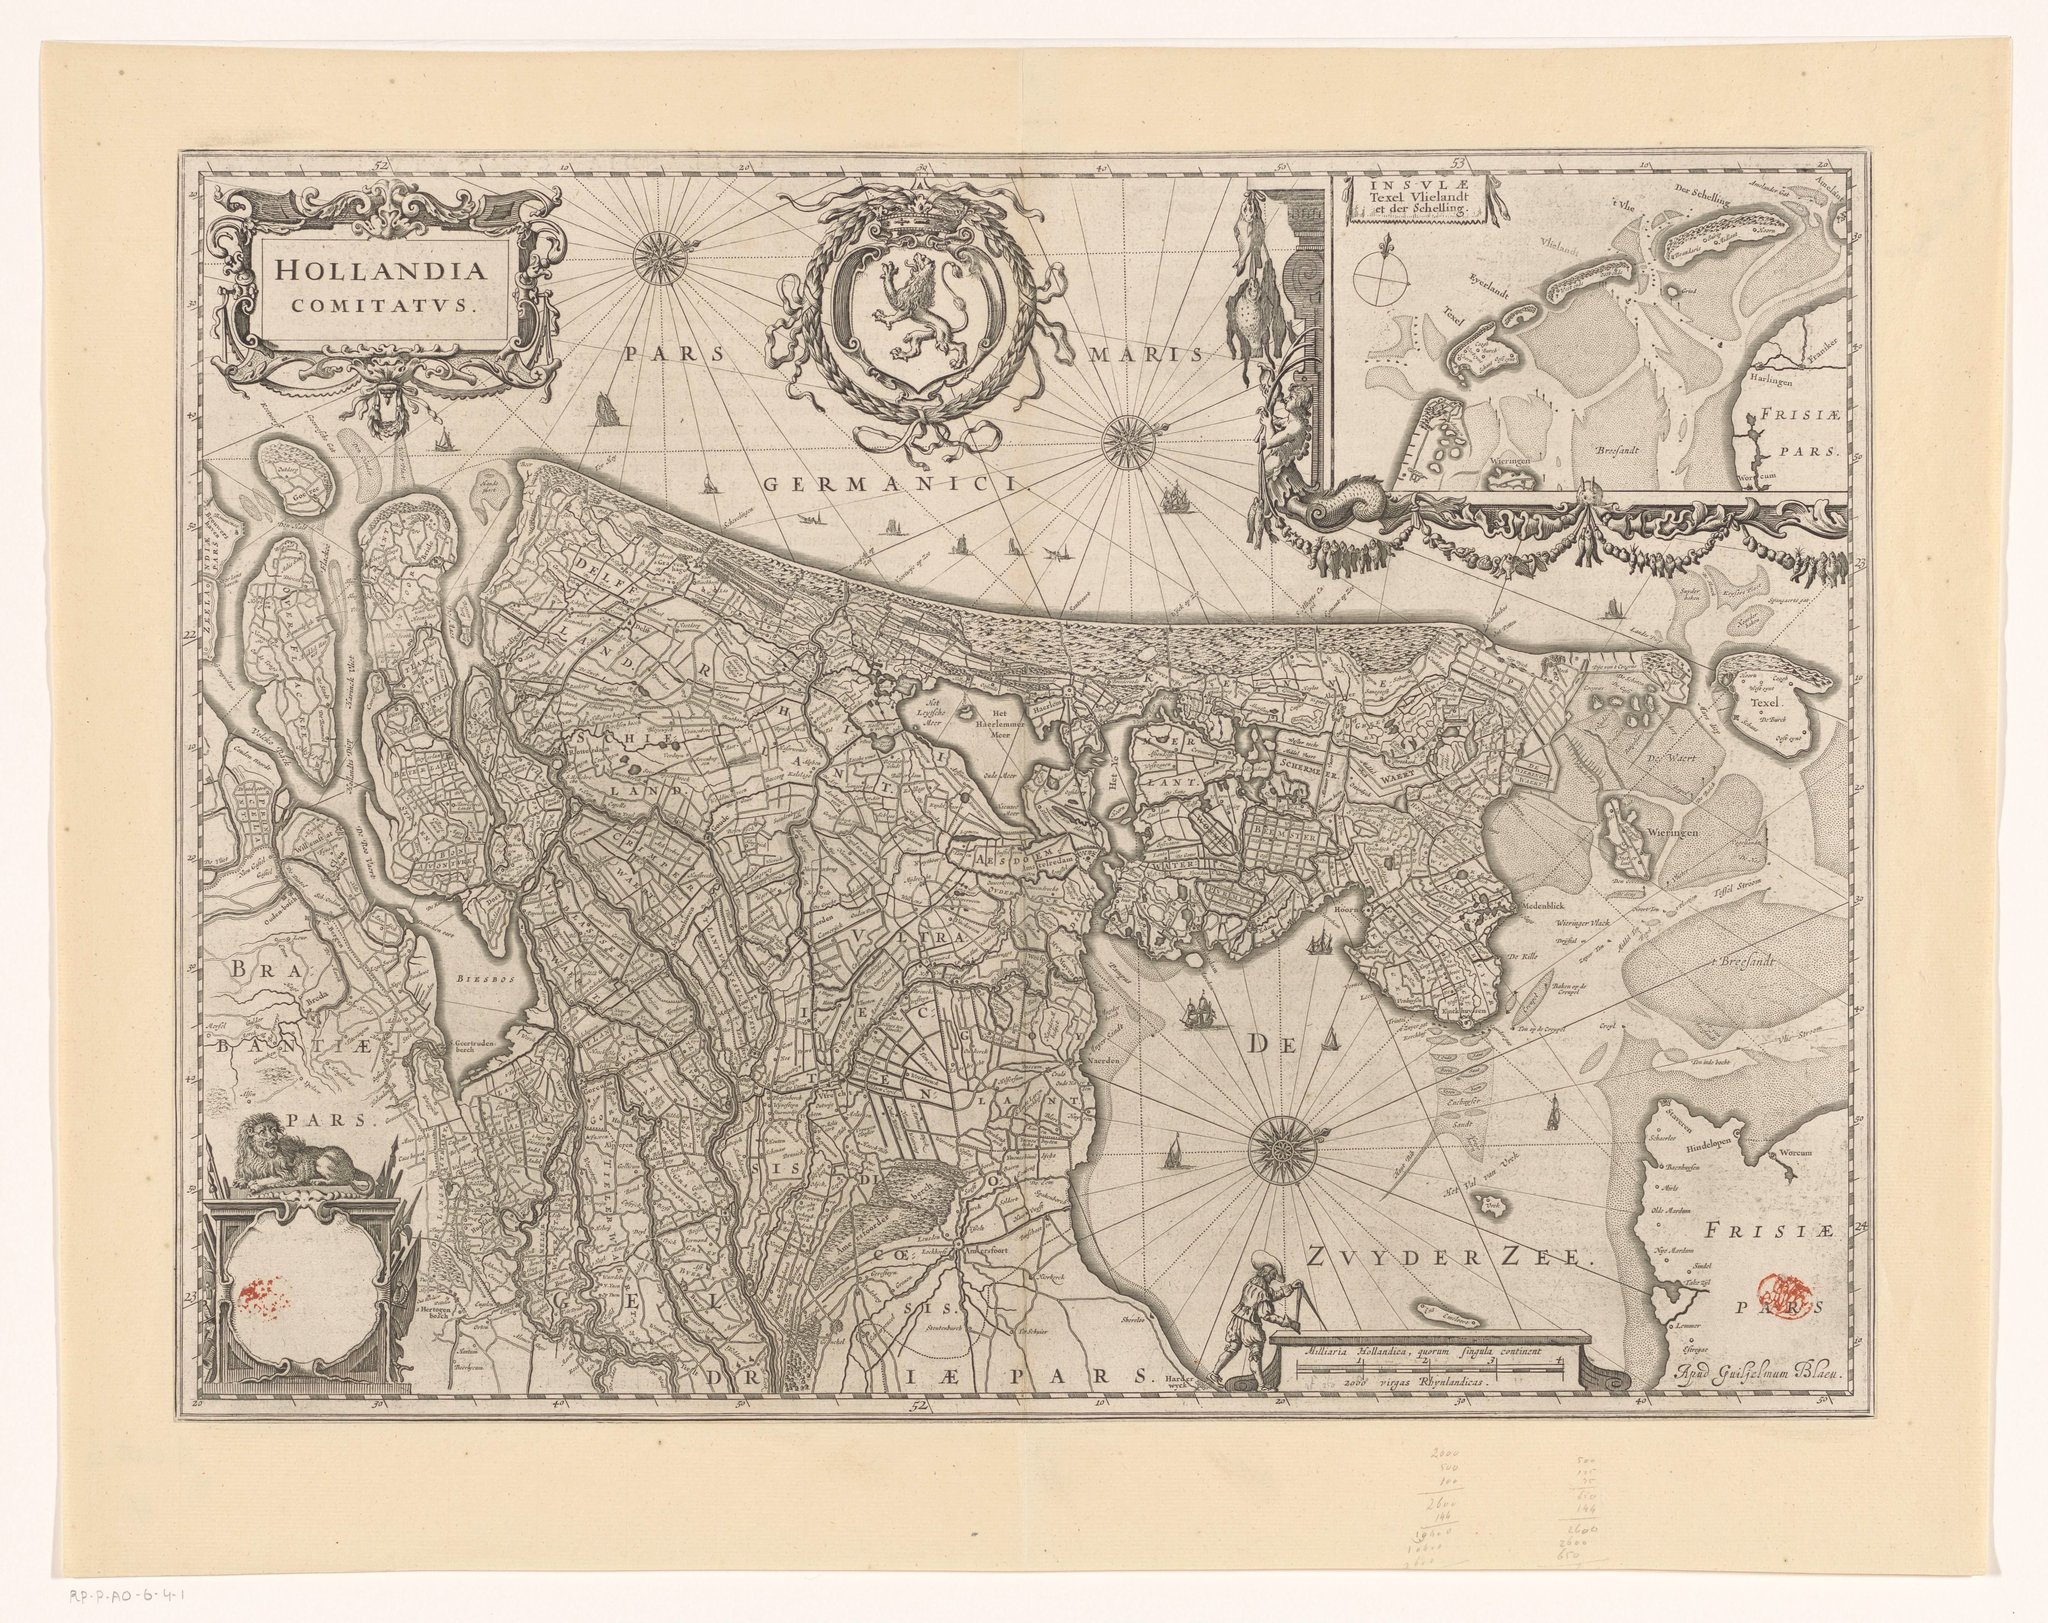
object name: print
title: Kaart van het graafschap Holland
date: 1634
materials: paper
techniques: engraving, etching, letterpress printing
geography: amsterdam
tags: coat of arms (as symbol of the state, etc.), maps of separate countries or regions, holland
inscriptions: collector's mark: Lugt 195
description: Kaart van het graafschap Holland en omliggende gebieden. Linksboven de titelcartouche, daarnaast het wapen van het graafschap Holland. Rechtsboven een inzetkaart van het Waddengebied. Linksonder een lege cartouche met daarop een leeuw. Rechtsonder een schaalstok: Milliaria Hollandica, quorum singula continent 2000 virgas Rhynlandicas. Gradenverdeling langs de randen. Oriëntatie: noorden rechts. Op verso Latijnse tekst.